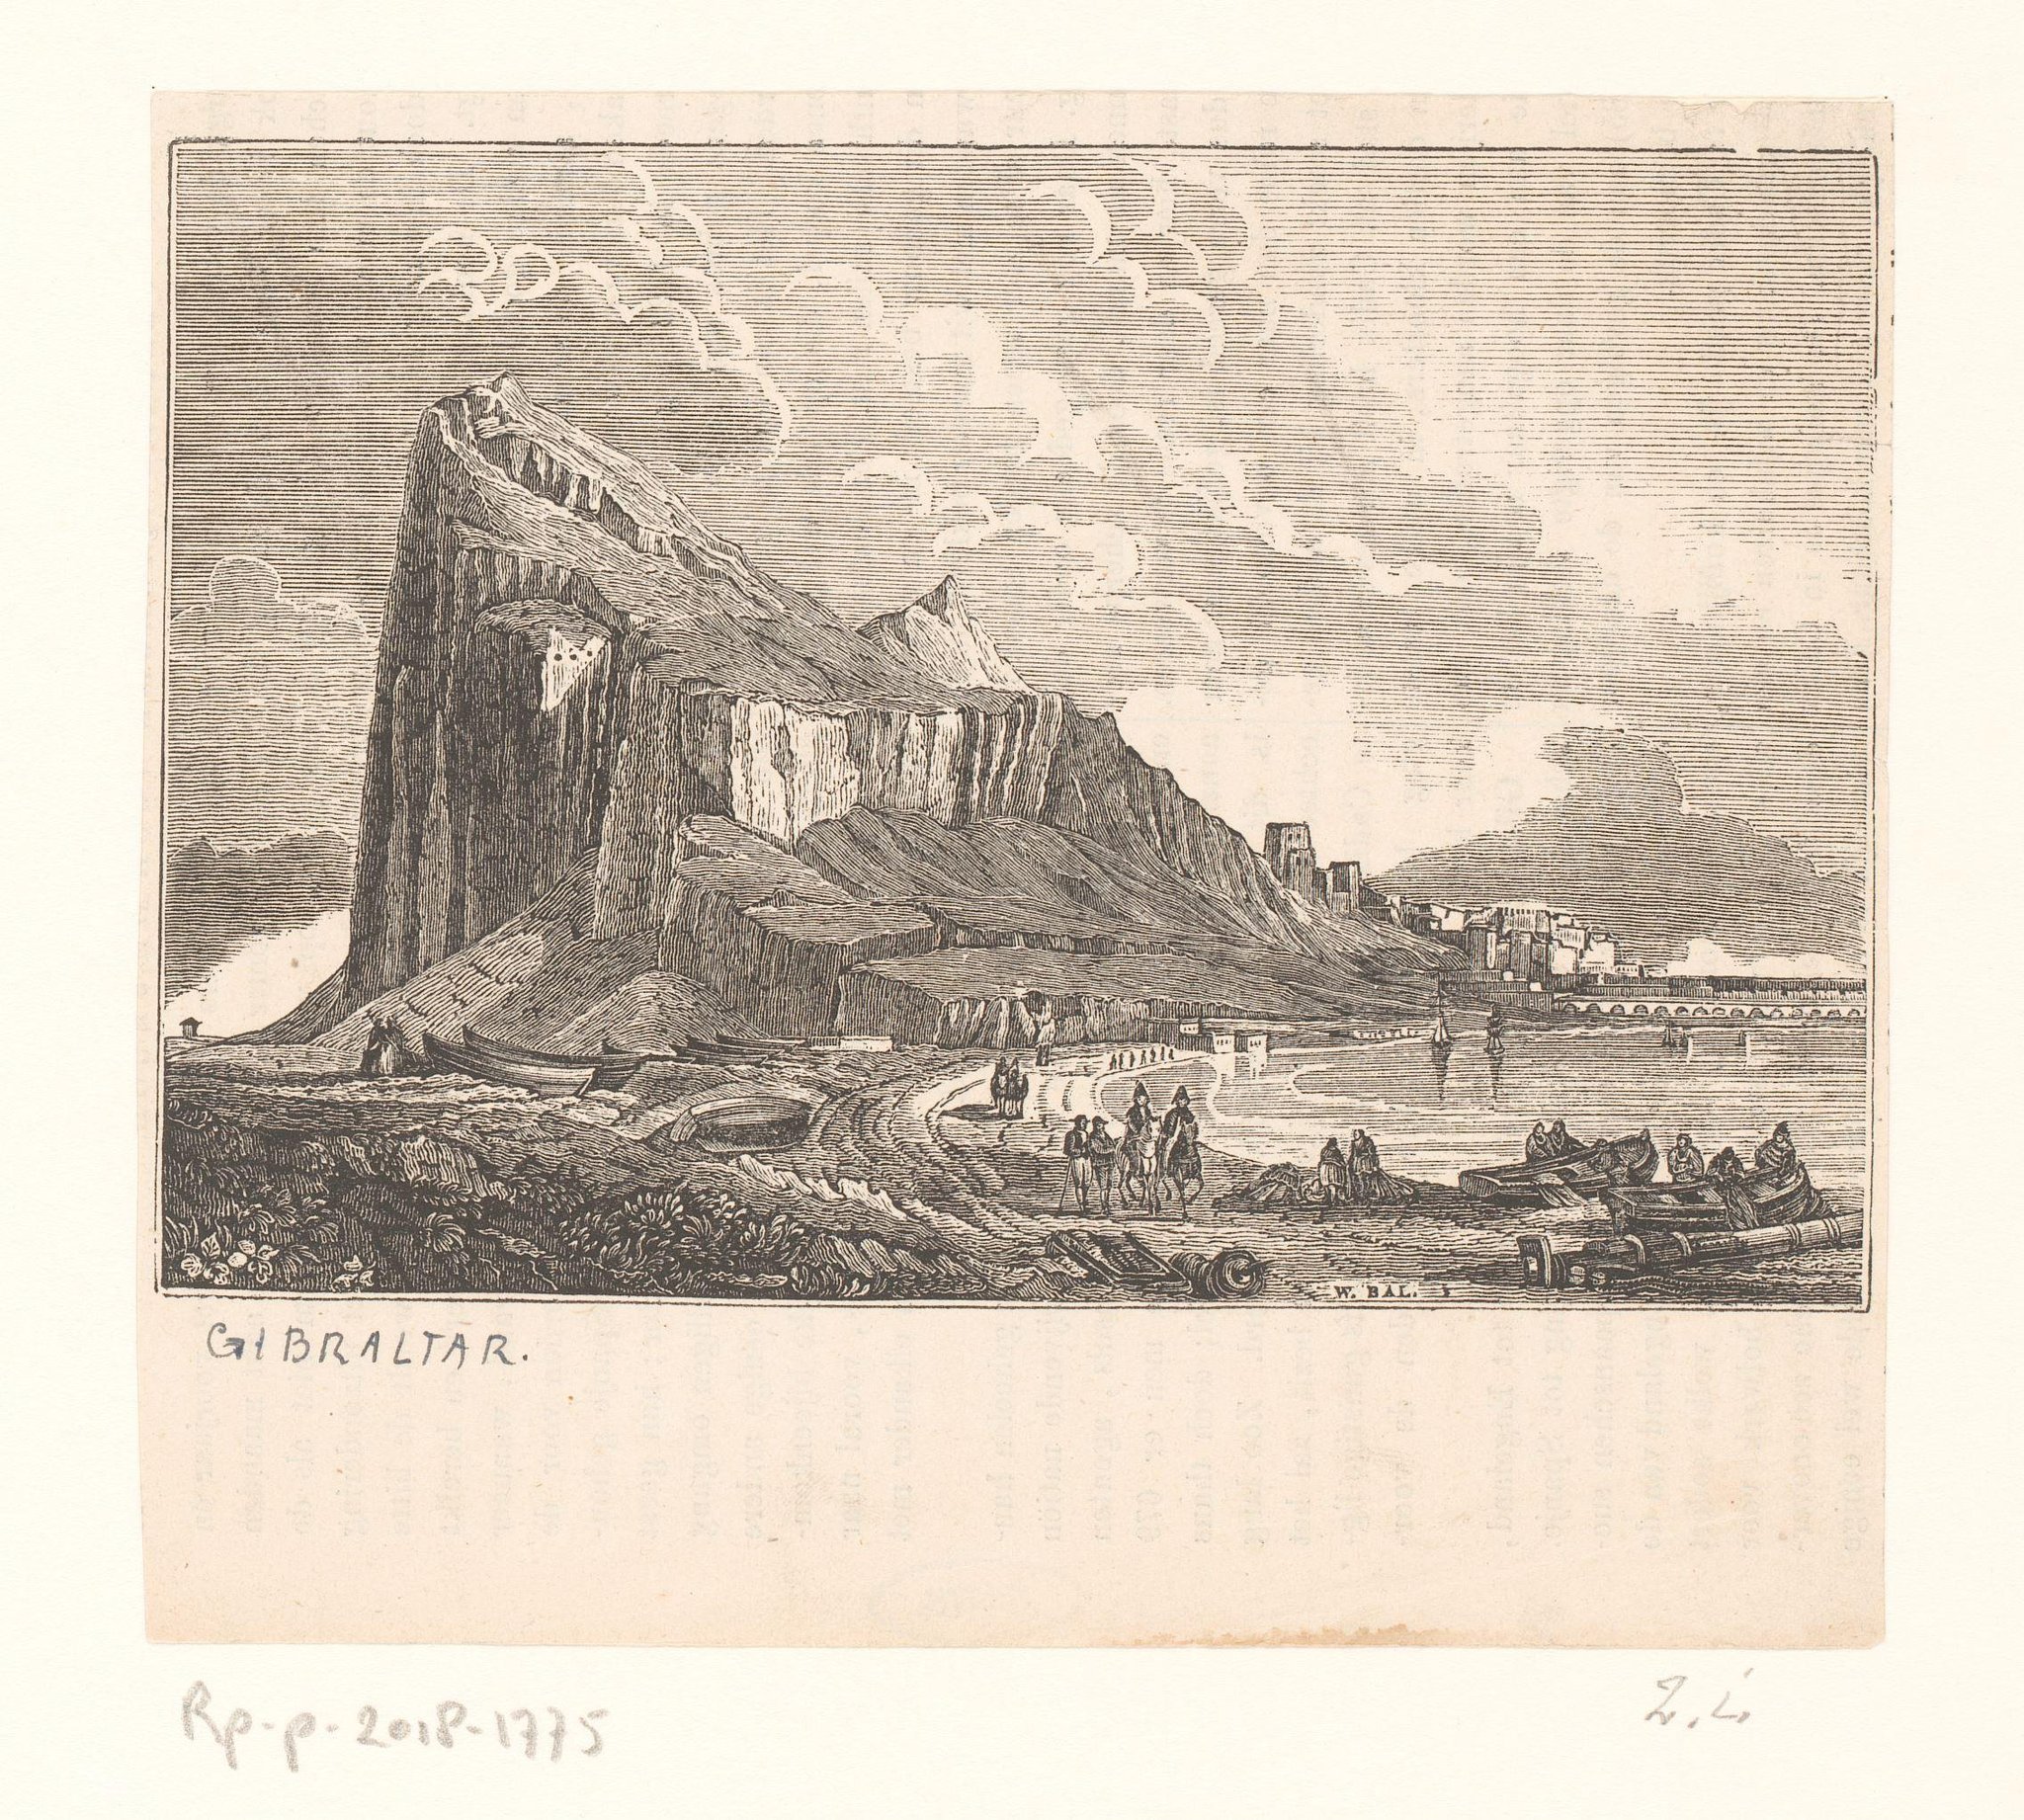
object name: print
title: Gezicht op Gibraltar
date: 1847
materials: paper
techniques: letterpress printing, engraving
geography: delft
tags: prospect of village, silhouette of village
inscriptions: collector's mark: Lugt 2228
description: Prent gebruikt in: Hollandsch Penning-Magazijn voor de jeugd. Amsterdam: J.H. Laarman, 1847.